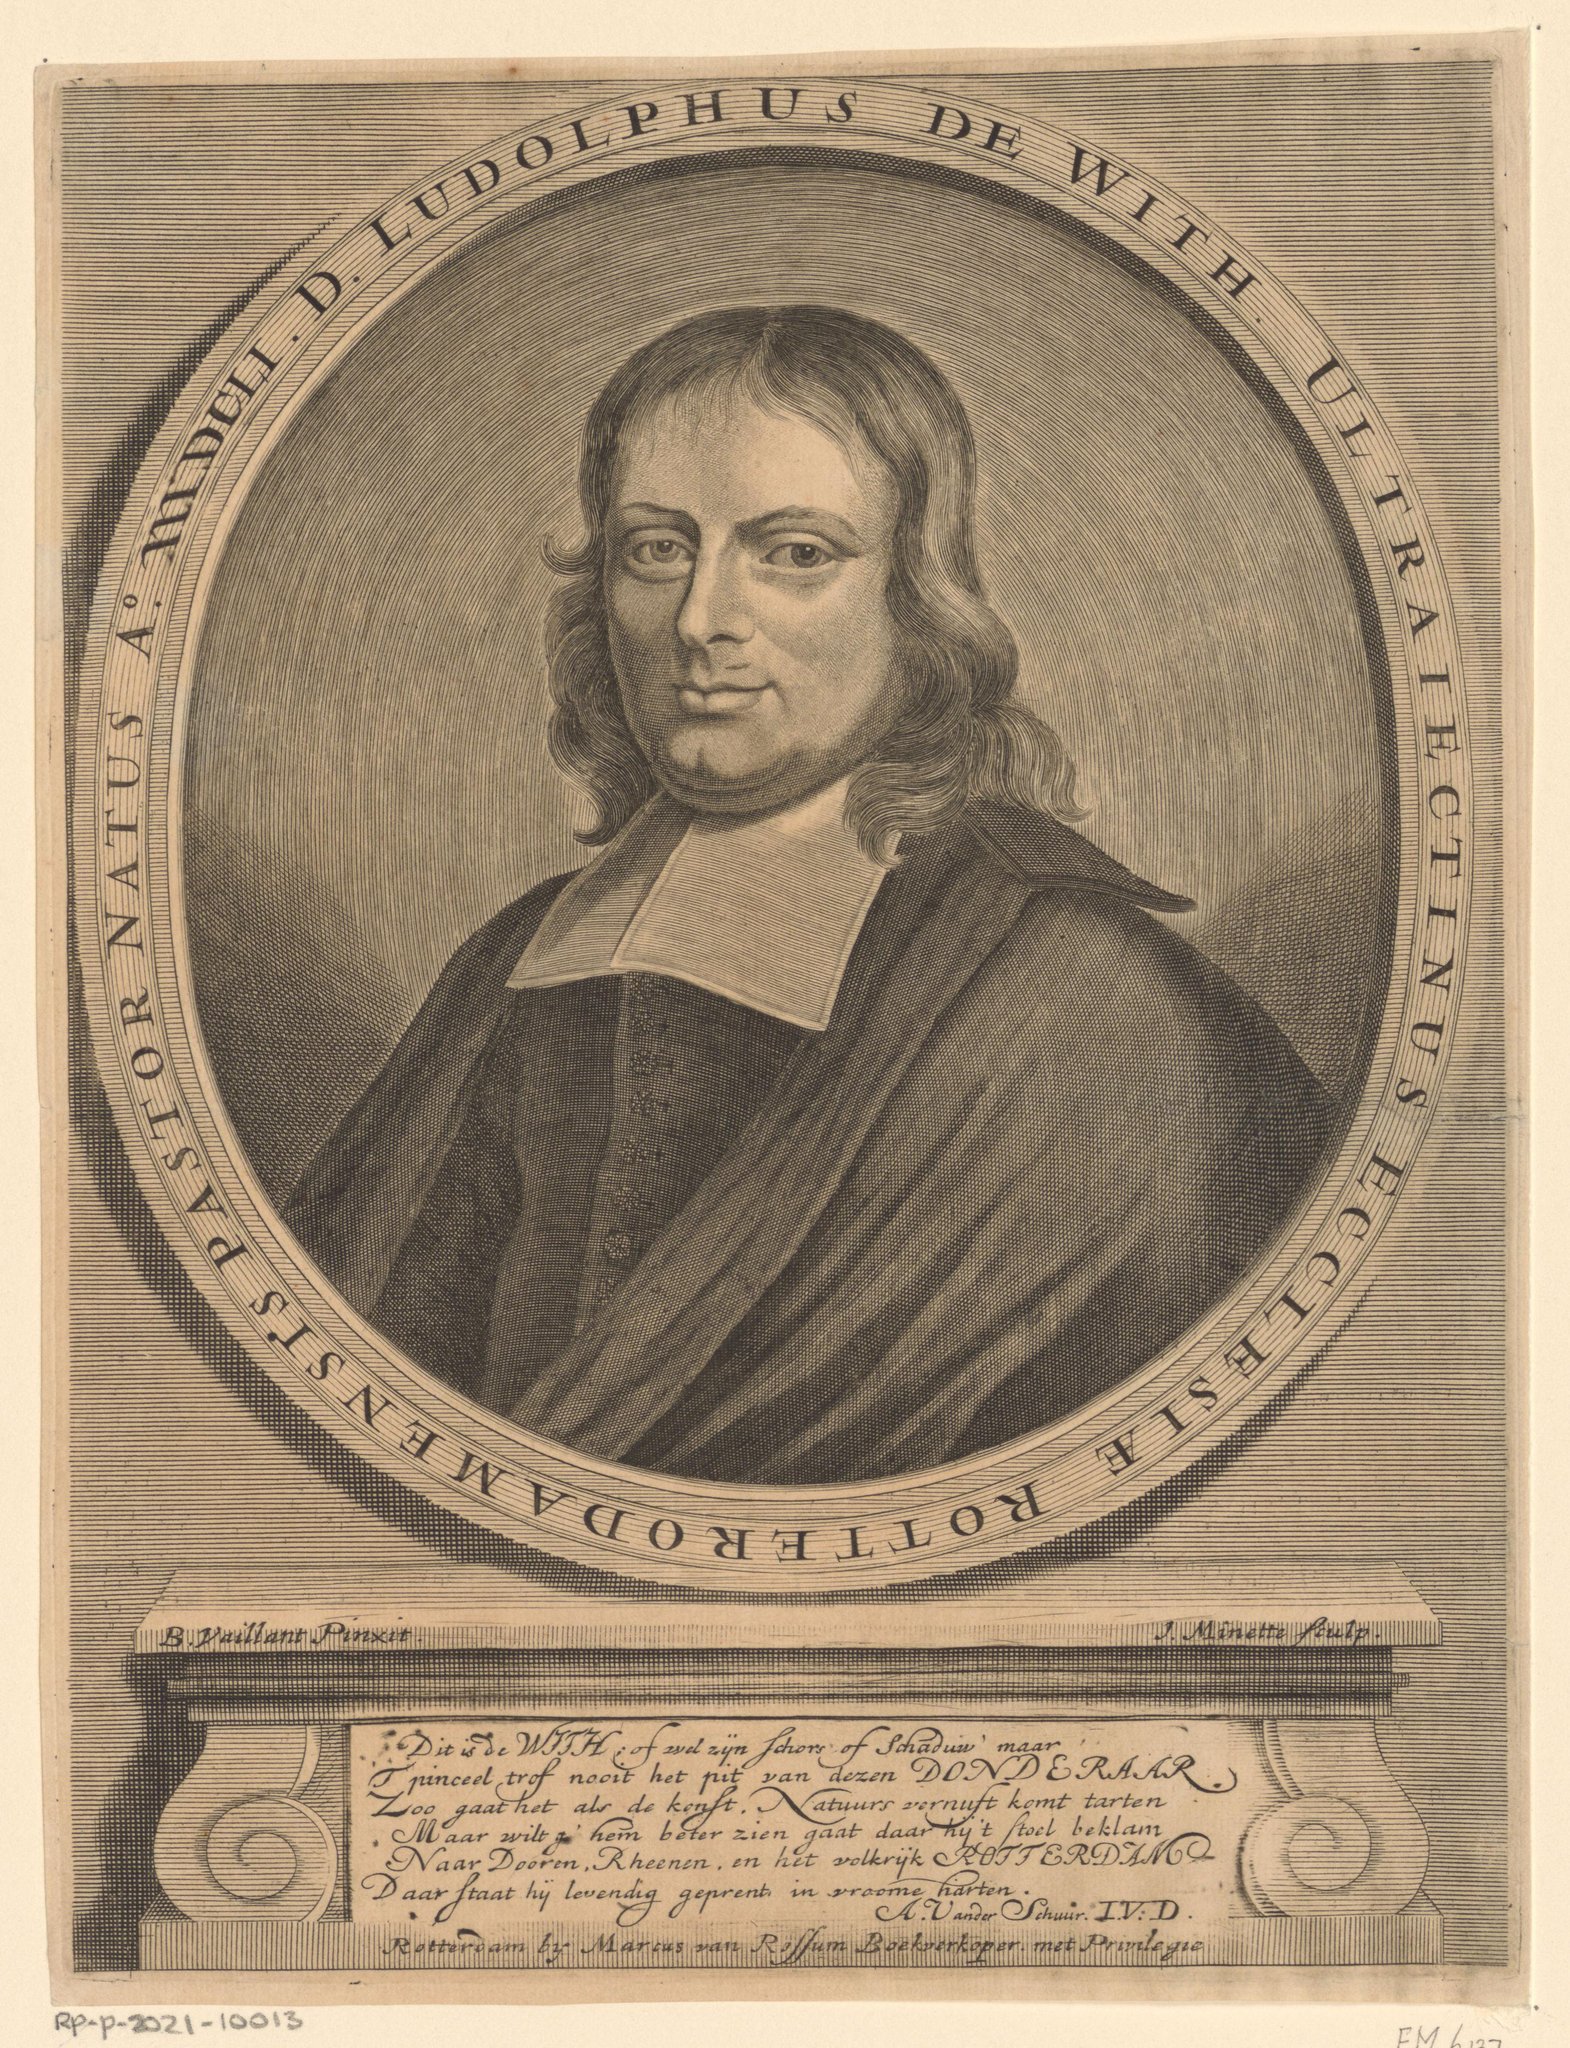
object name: print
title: Portret van Ludolfus de With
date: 1683-1684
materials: paper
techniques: engraving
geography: rotterdam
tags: utrecht, rotterdam, historical persons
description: Portret van Ludolfus de With, predikant te Doorn, Rhenen en Rotterdam. Onder het portret zes regels Nederlandse tekst.